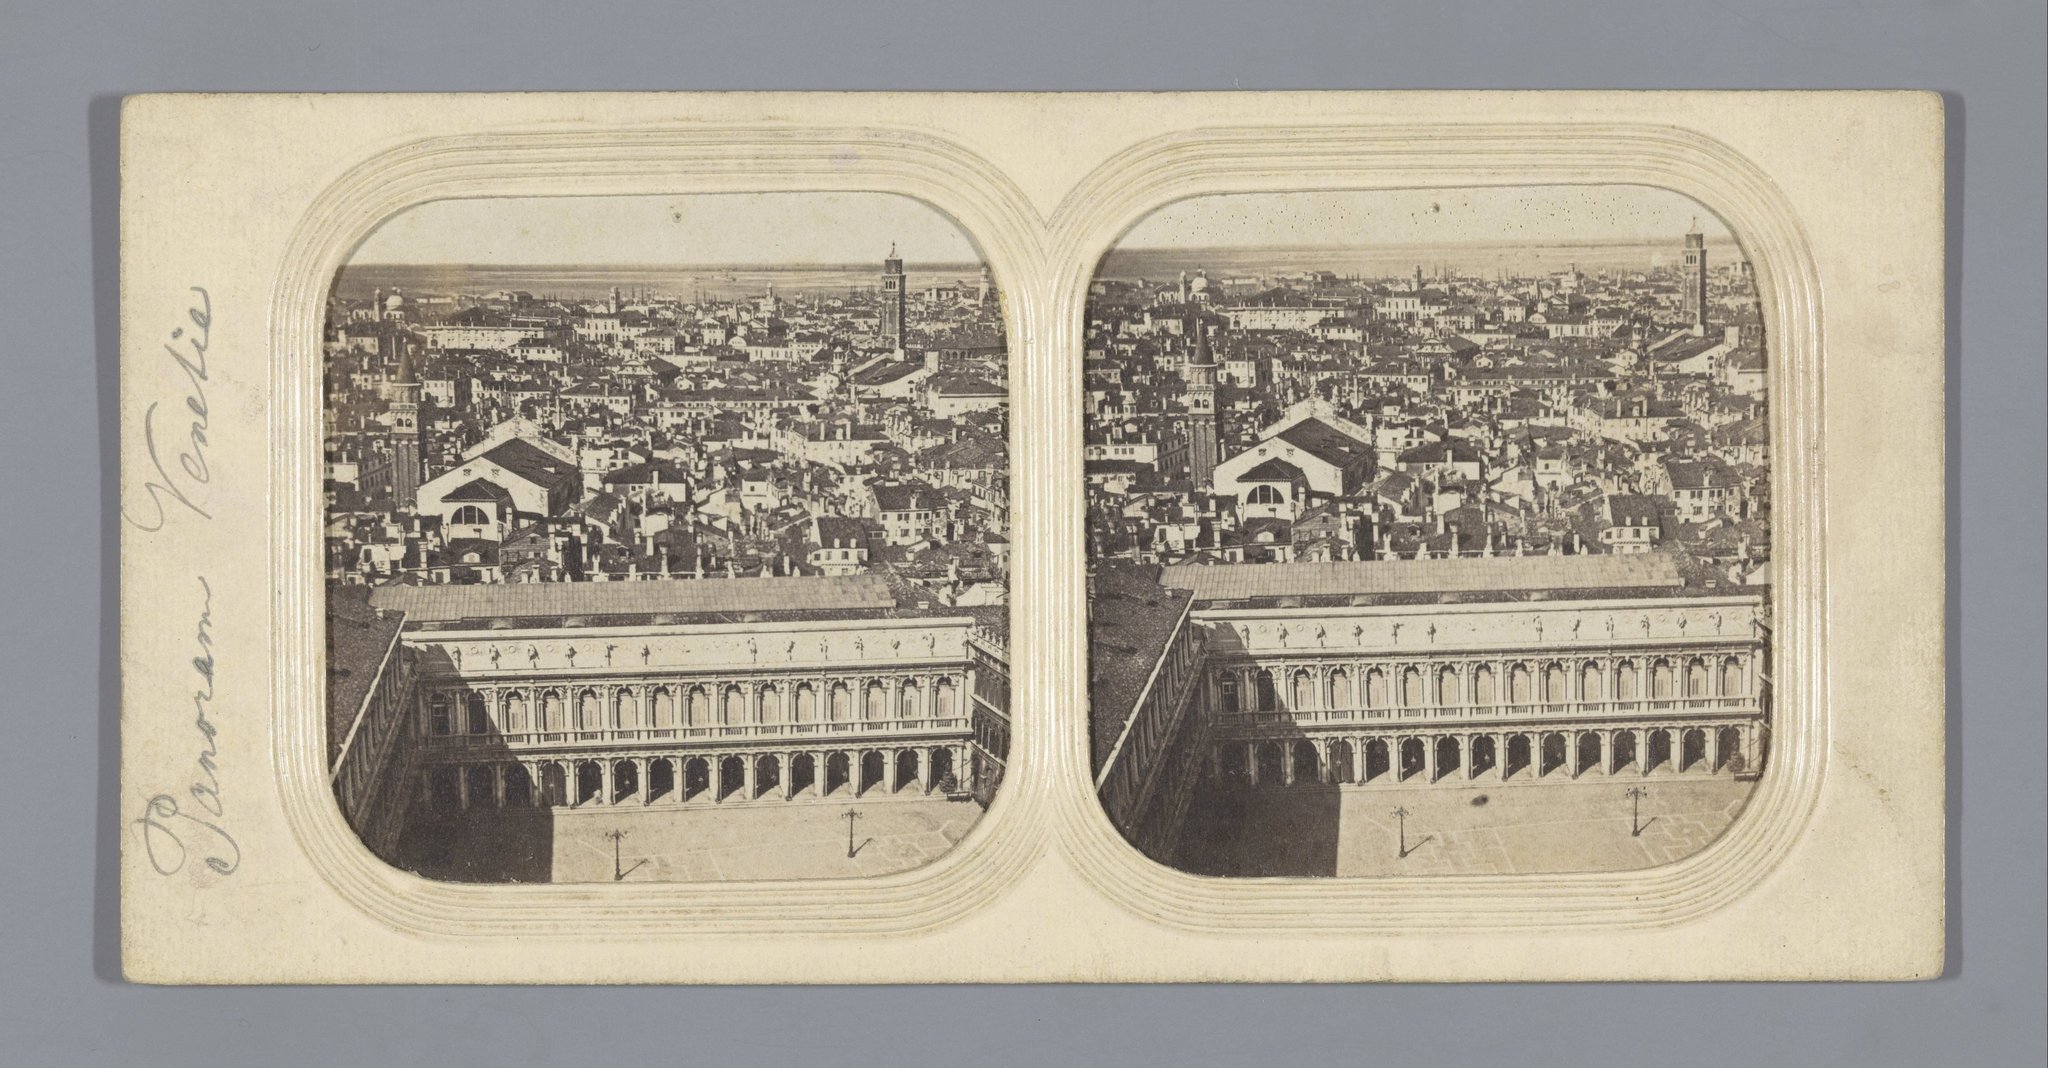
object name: tissue stereograph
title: Panorama Venetie / Venise, Panorama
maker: Anonymous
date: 1855-1875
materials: cardboard, paper, photographic support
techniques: albumen print, hand coloring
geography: venice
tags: city-view in general; 'veduta', venice